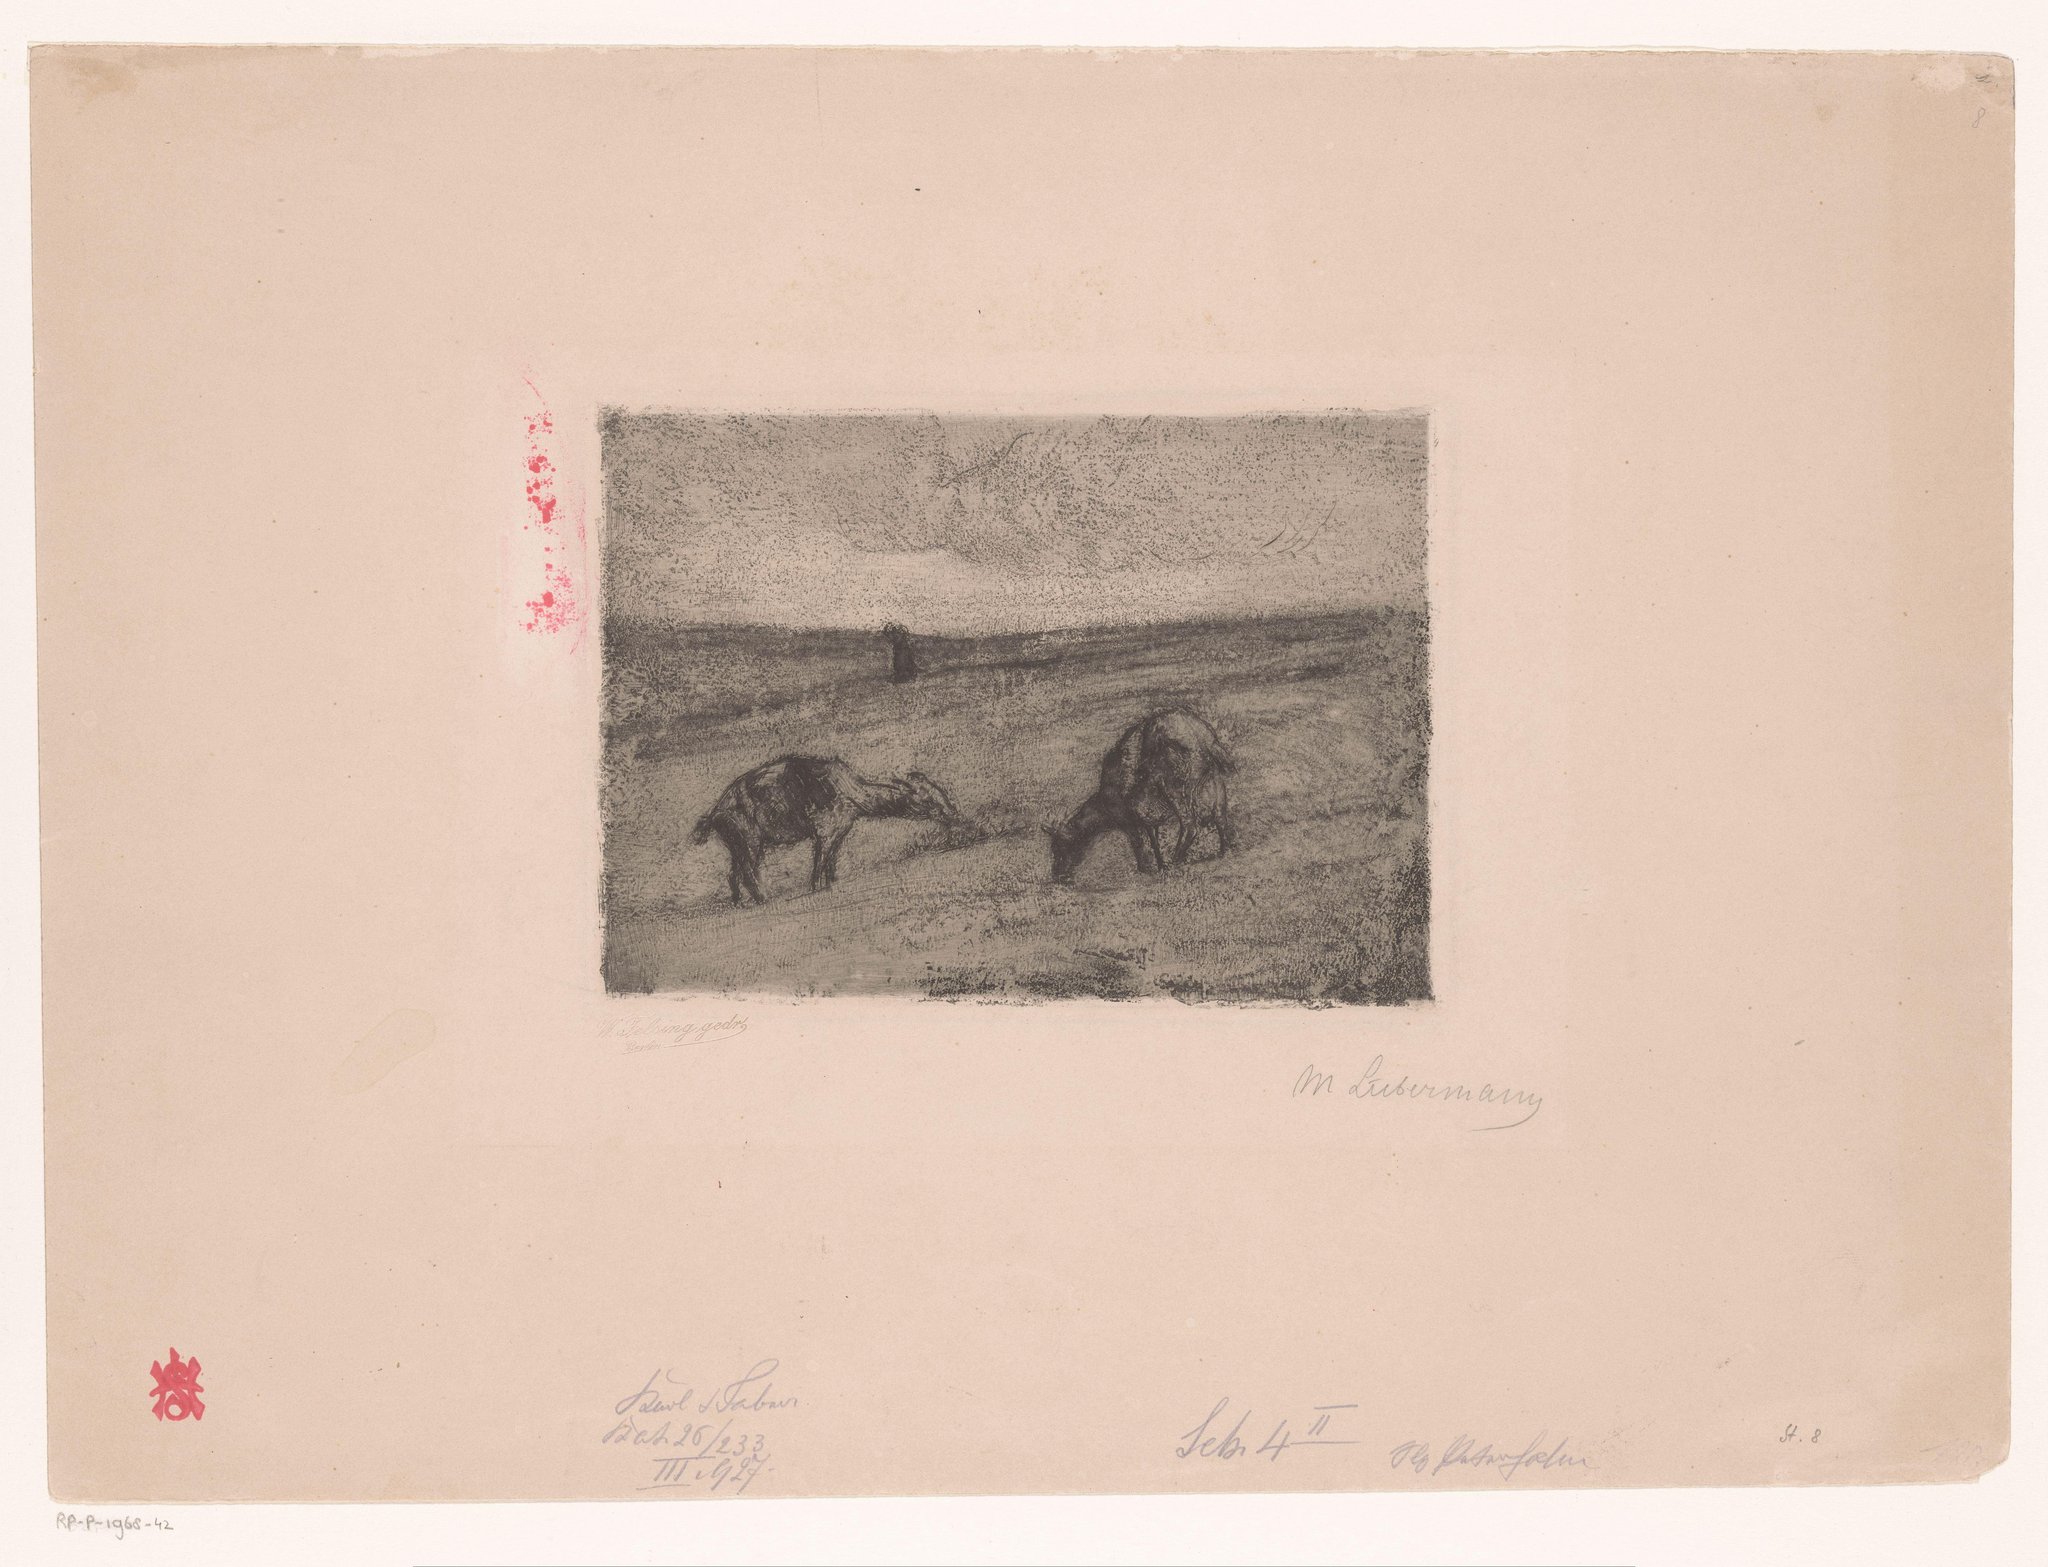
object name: print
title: Landschap met grazende geiten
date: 1857-1935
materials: paper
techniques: drypoint, etching, soft ground etching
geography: berlin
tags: goat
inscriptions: collector's mark: Lugt 2373a, inscription: ‘Karl u Faber Cat. 26/233 III 1927’, collector's mark: Lugt 2228, collector's mark: Lugt 1376a